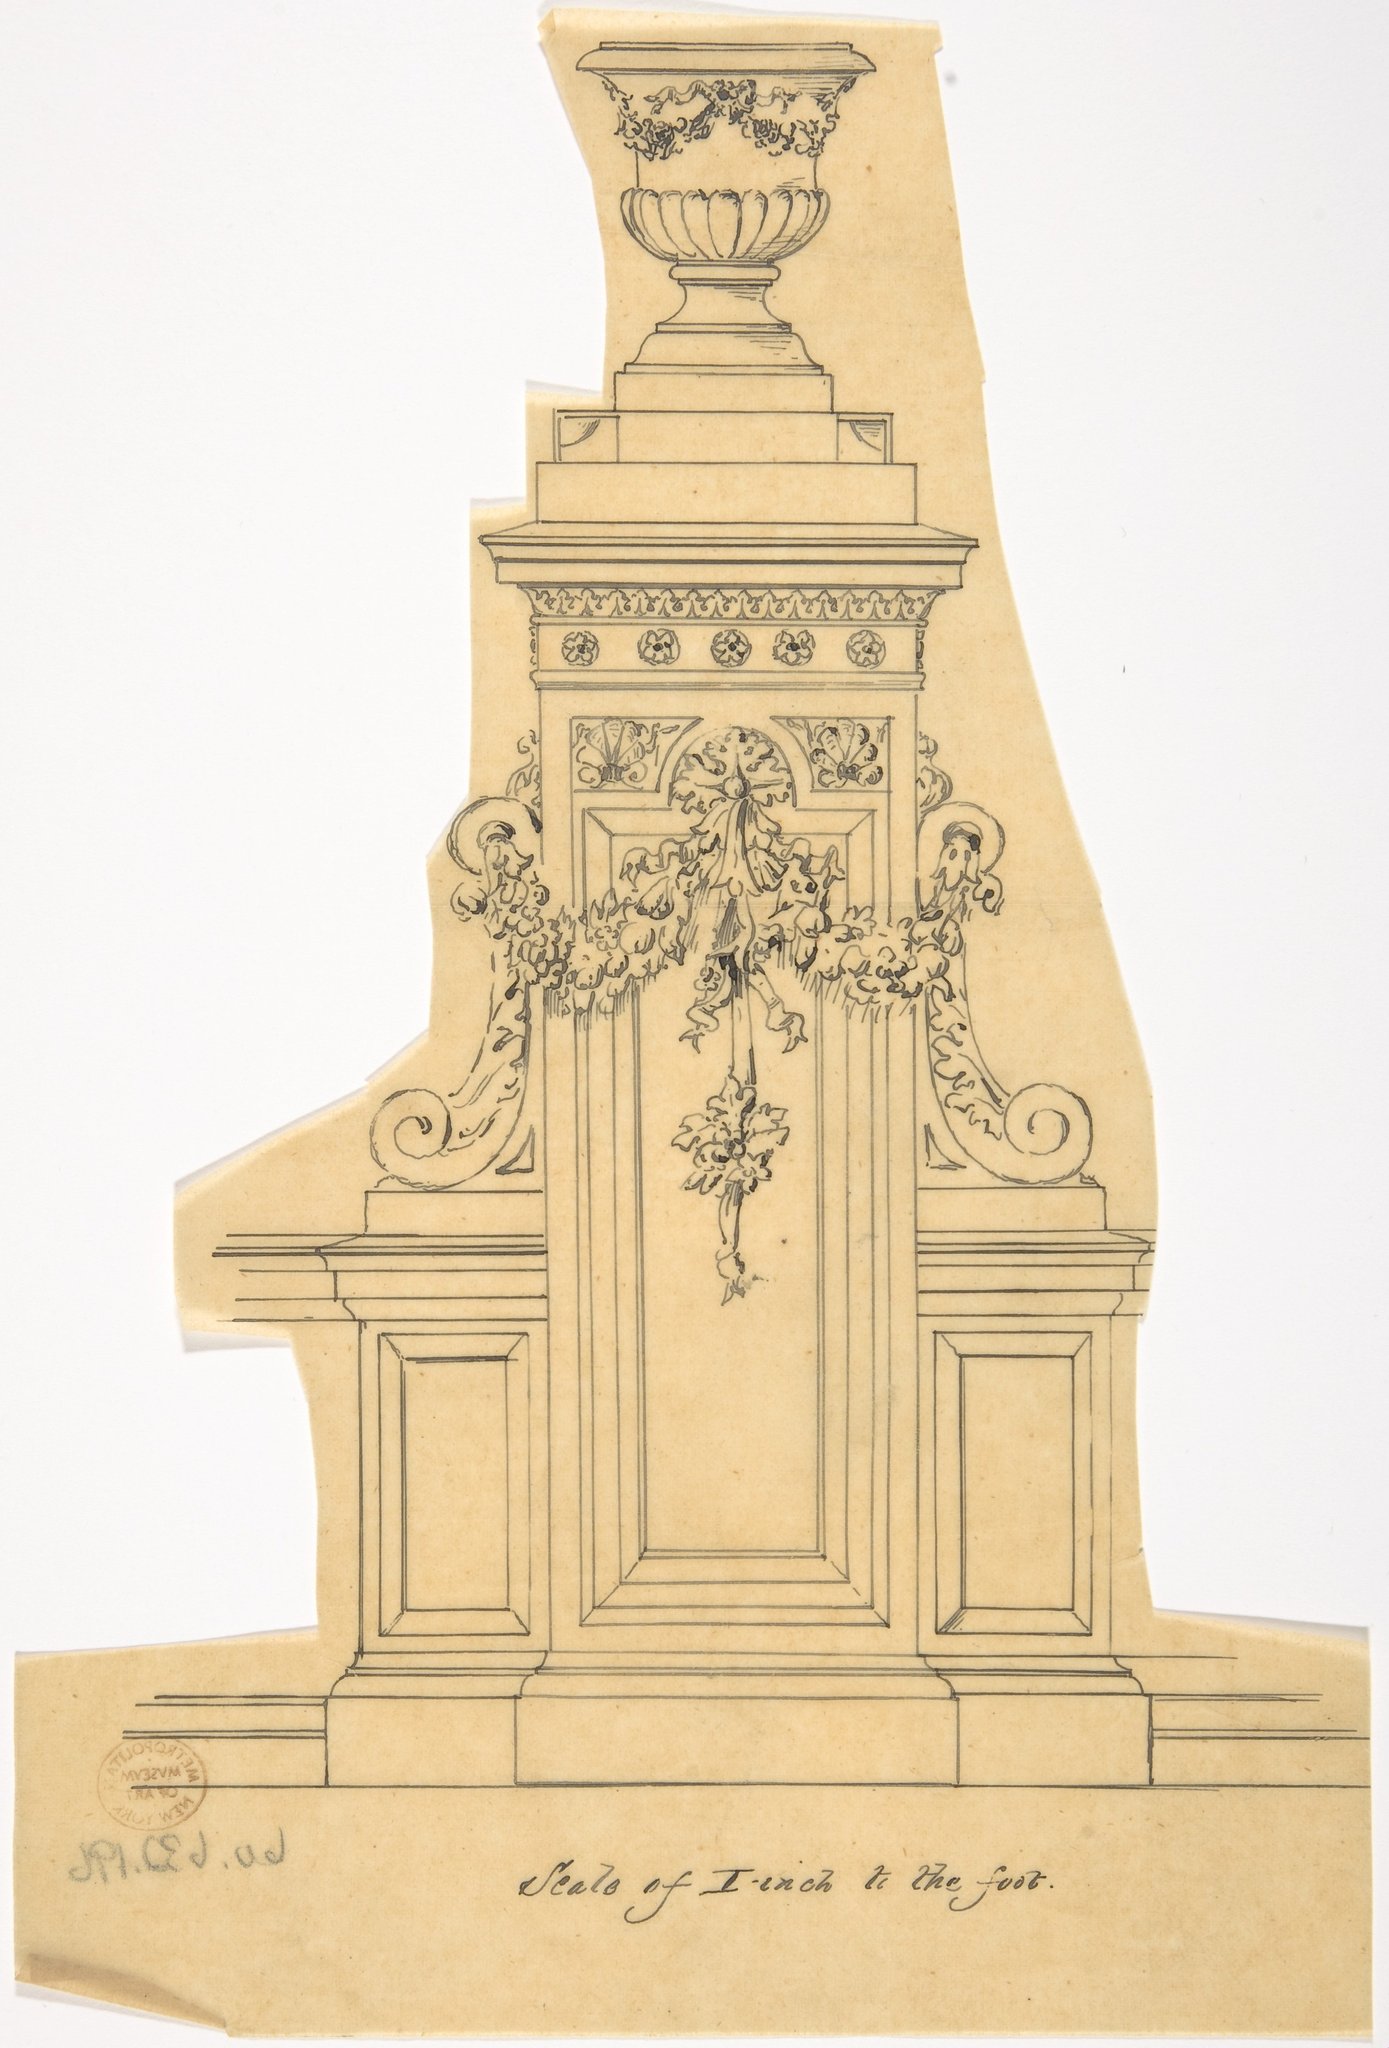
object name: drawing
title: Carved Pedestal Supporting a Vase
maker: anonymous, british, 19th century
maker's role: artist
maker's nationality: british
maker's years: 1800-1900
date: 1801-1900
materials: ink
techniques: pen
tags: vases